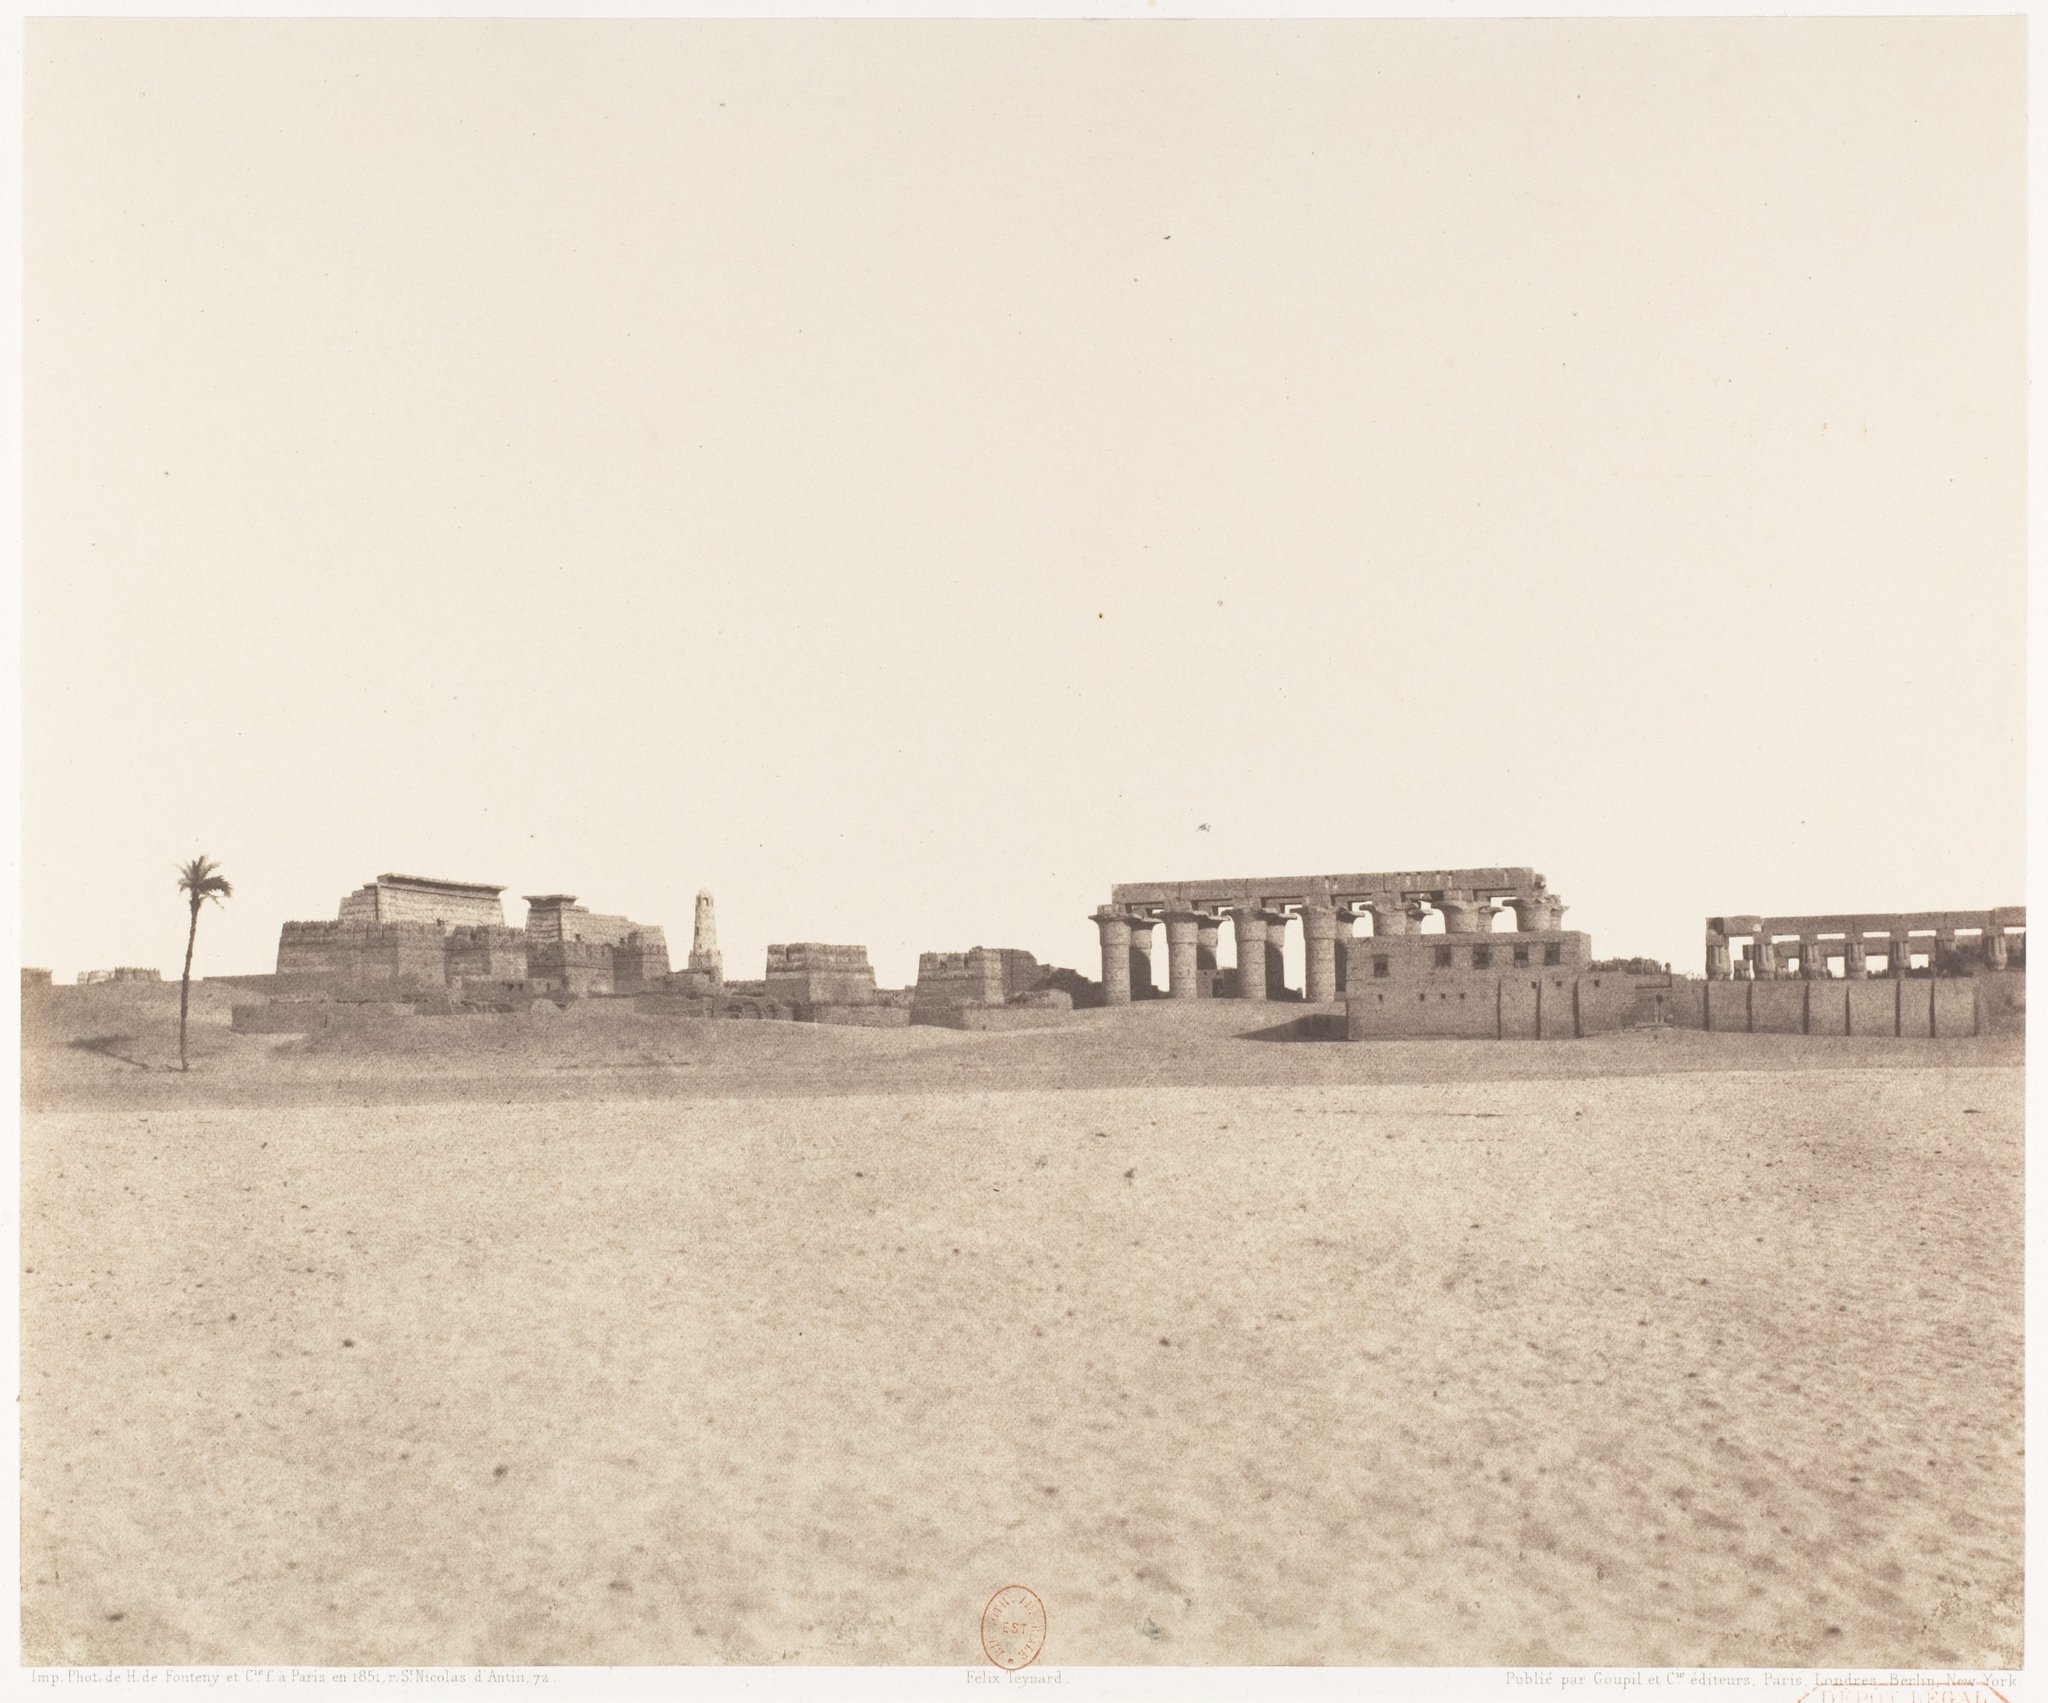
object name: photograph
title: Louksor (Thèbes), Vue Générale des Ruines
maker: félix teynard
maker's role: artist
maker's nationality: french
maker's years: 1817-1892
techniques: paper negative, salted paper print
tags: architecture,ruins